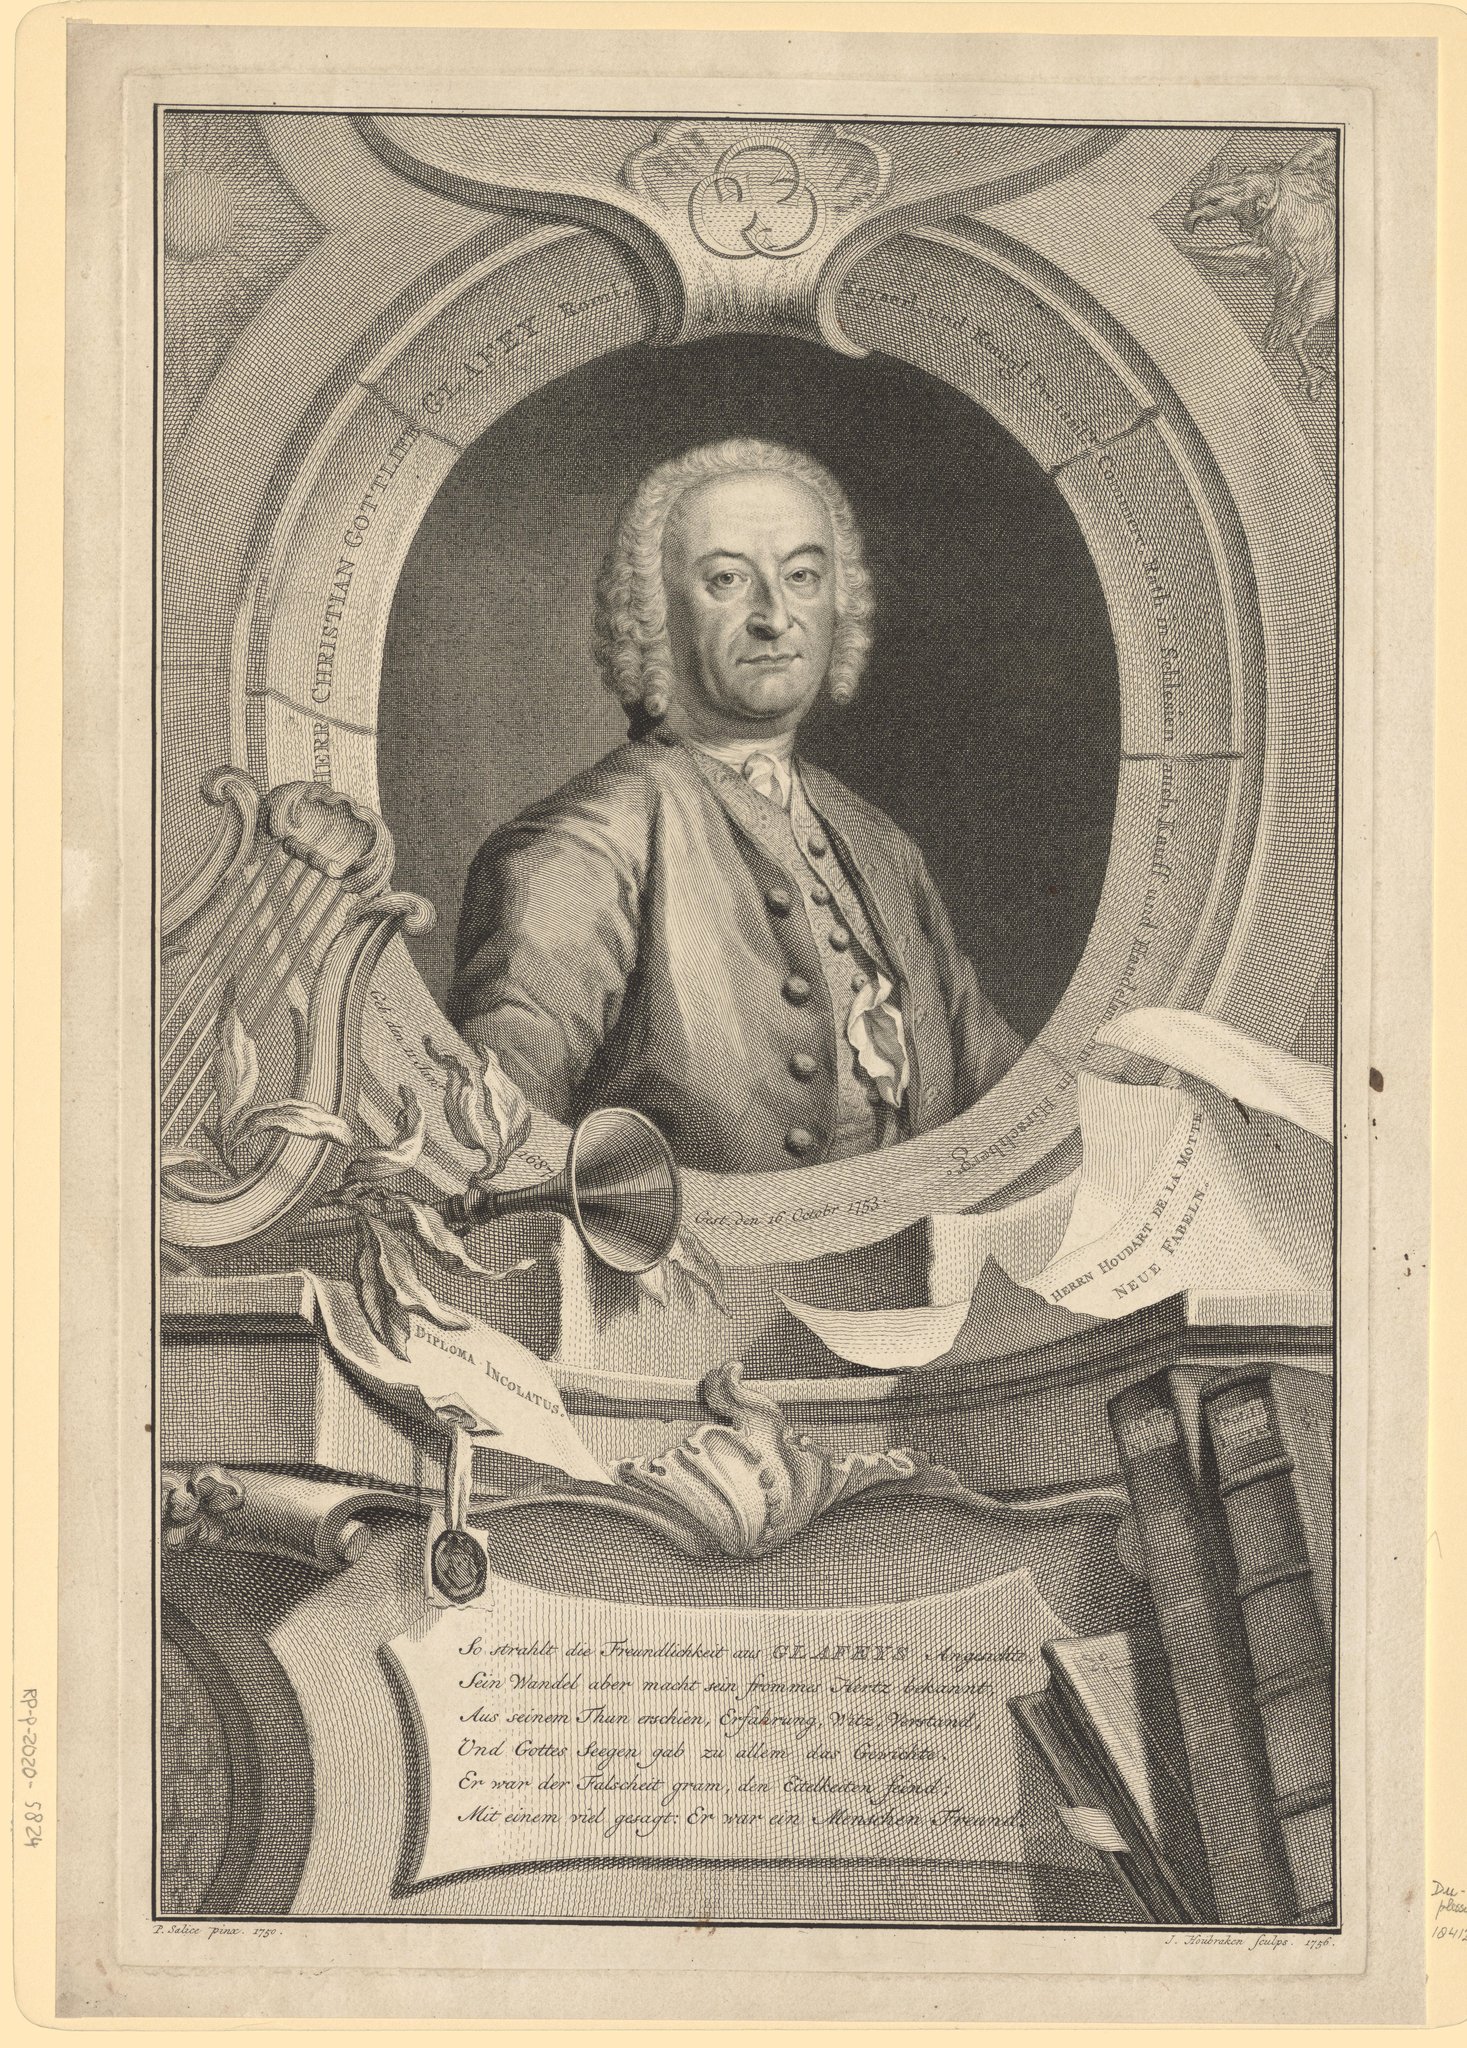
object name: print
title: Portret van Christian Gottlieb Glafey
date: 1750-1756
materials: paper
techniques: engraving, etching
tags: historical persons, portrait of a writer, scholar, philosopher (+ portrait of scholar, scientist)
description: De in de prent verwerkte tekst verwijst naar het boek: Houdar de La Motte, Antoine. Herrn Houdart de La Motte Neue Fabeln. [vertaald uit het Frans vertaald door] Christian Gottlieb Glafey. Leipzig: Gottlieb Siegert, 1736.